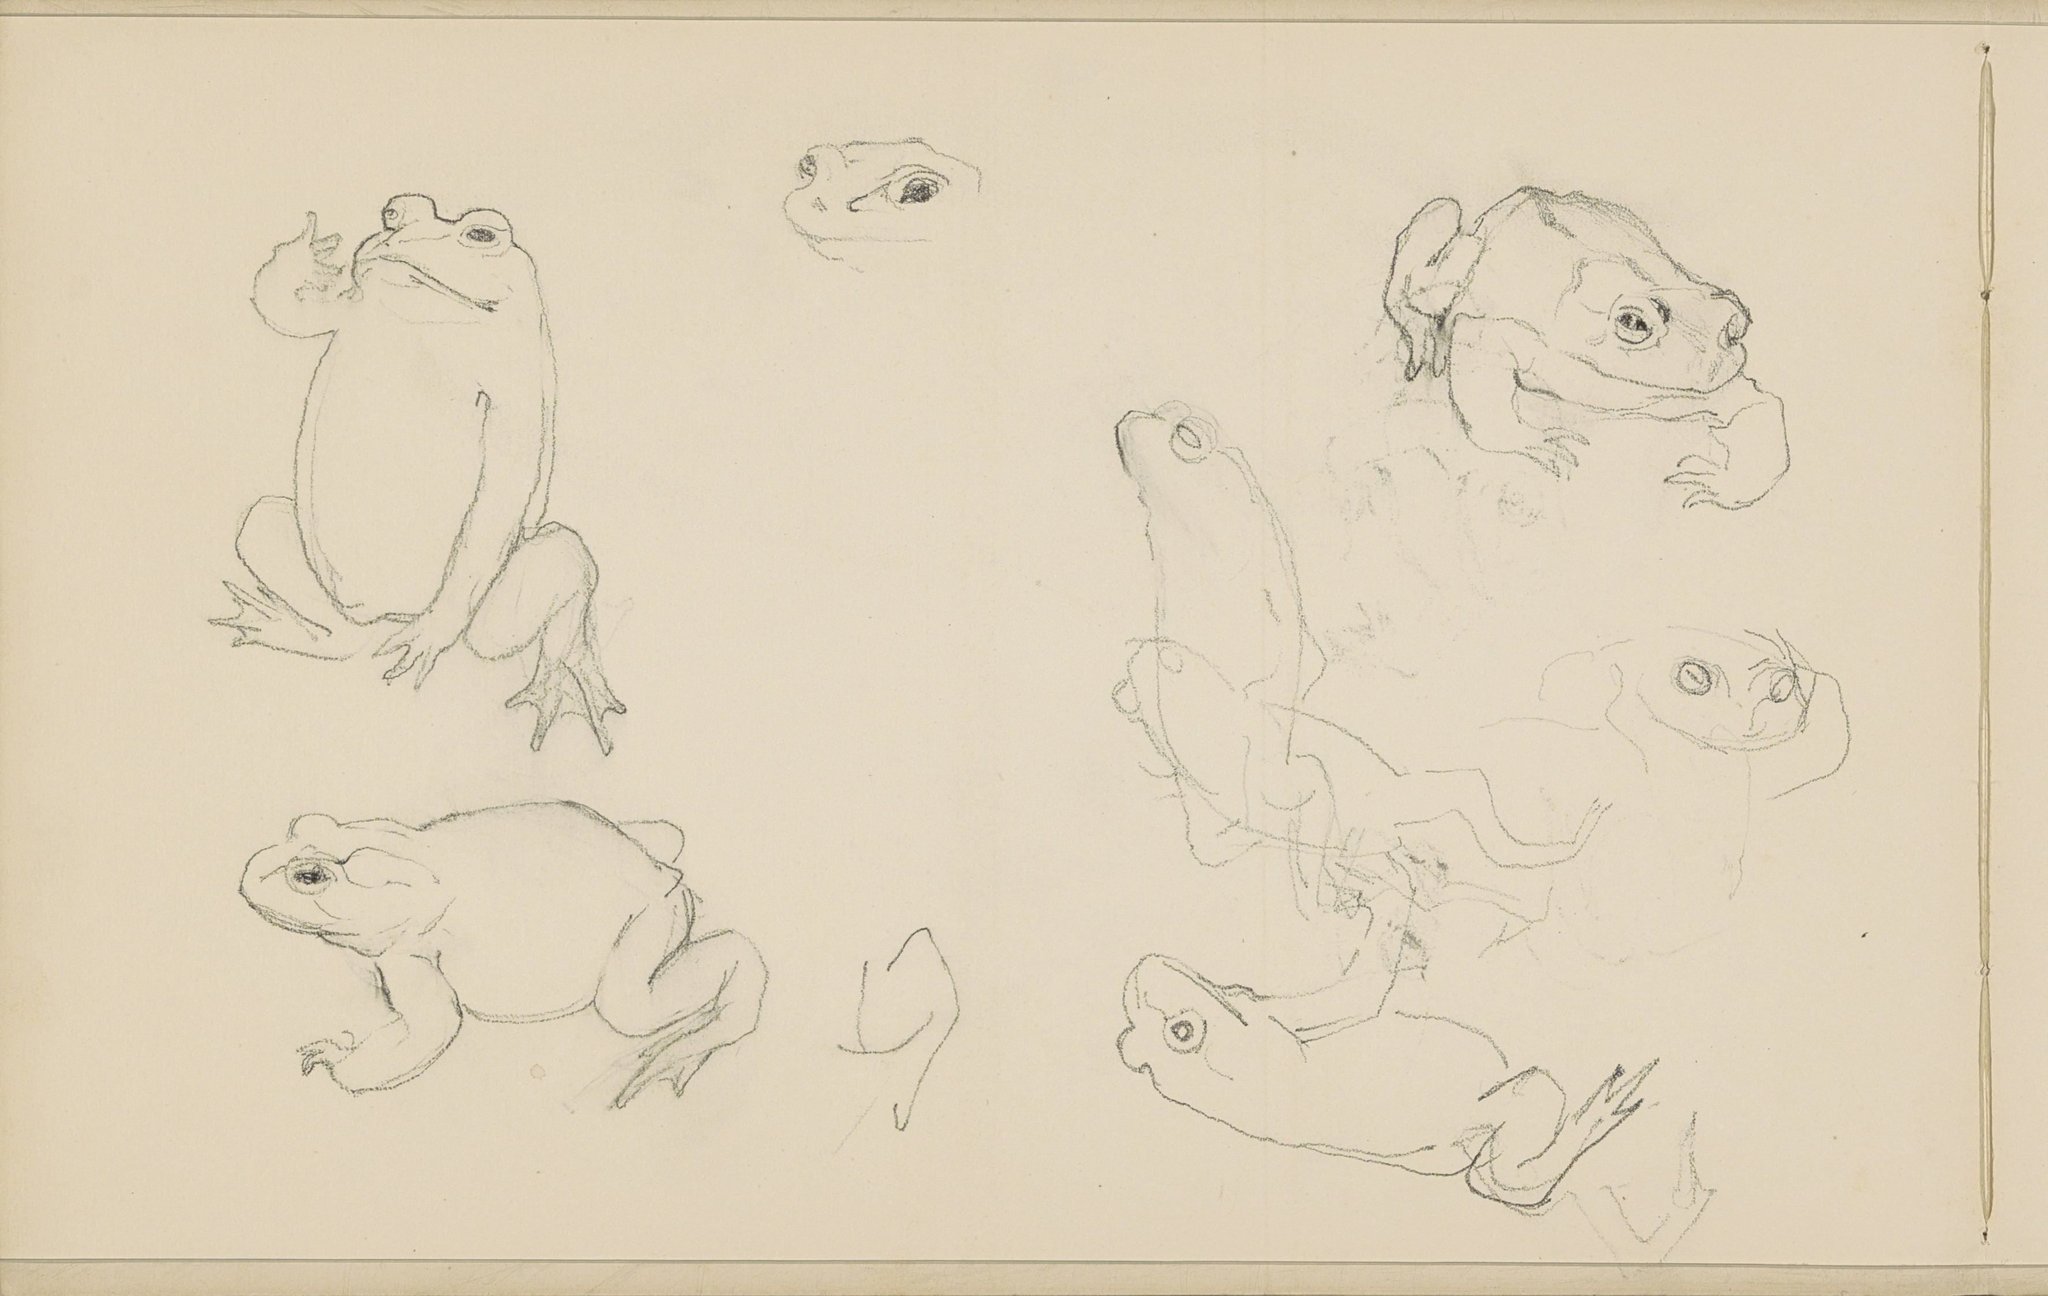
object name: sketchbook leaf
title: Kikkers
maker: a.a.l. de grammont-hubrecht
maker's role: draughtsman, painter, print maker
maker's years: 1855-1913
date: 1865-1913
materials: paper, pencil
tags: tailless amphibians: frog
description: Blad 44 verso uit een schetsboek met 65 bladen.